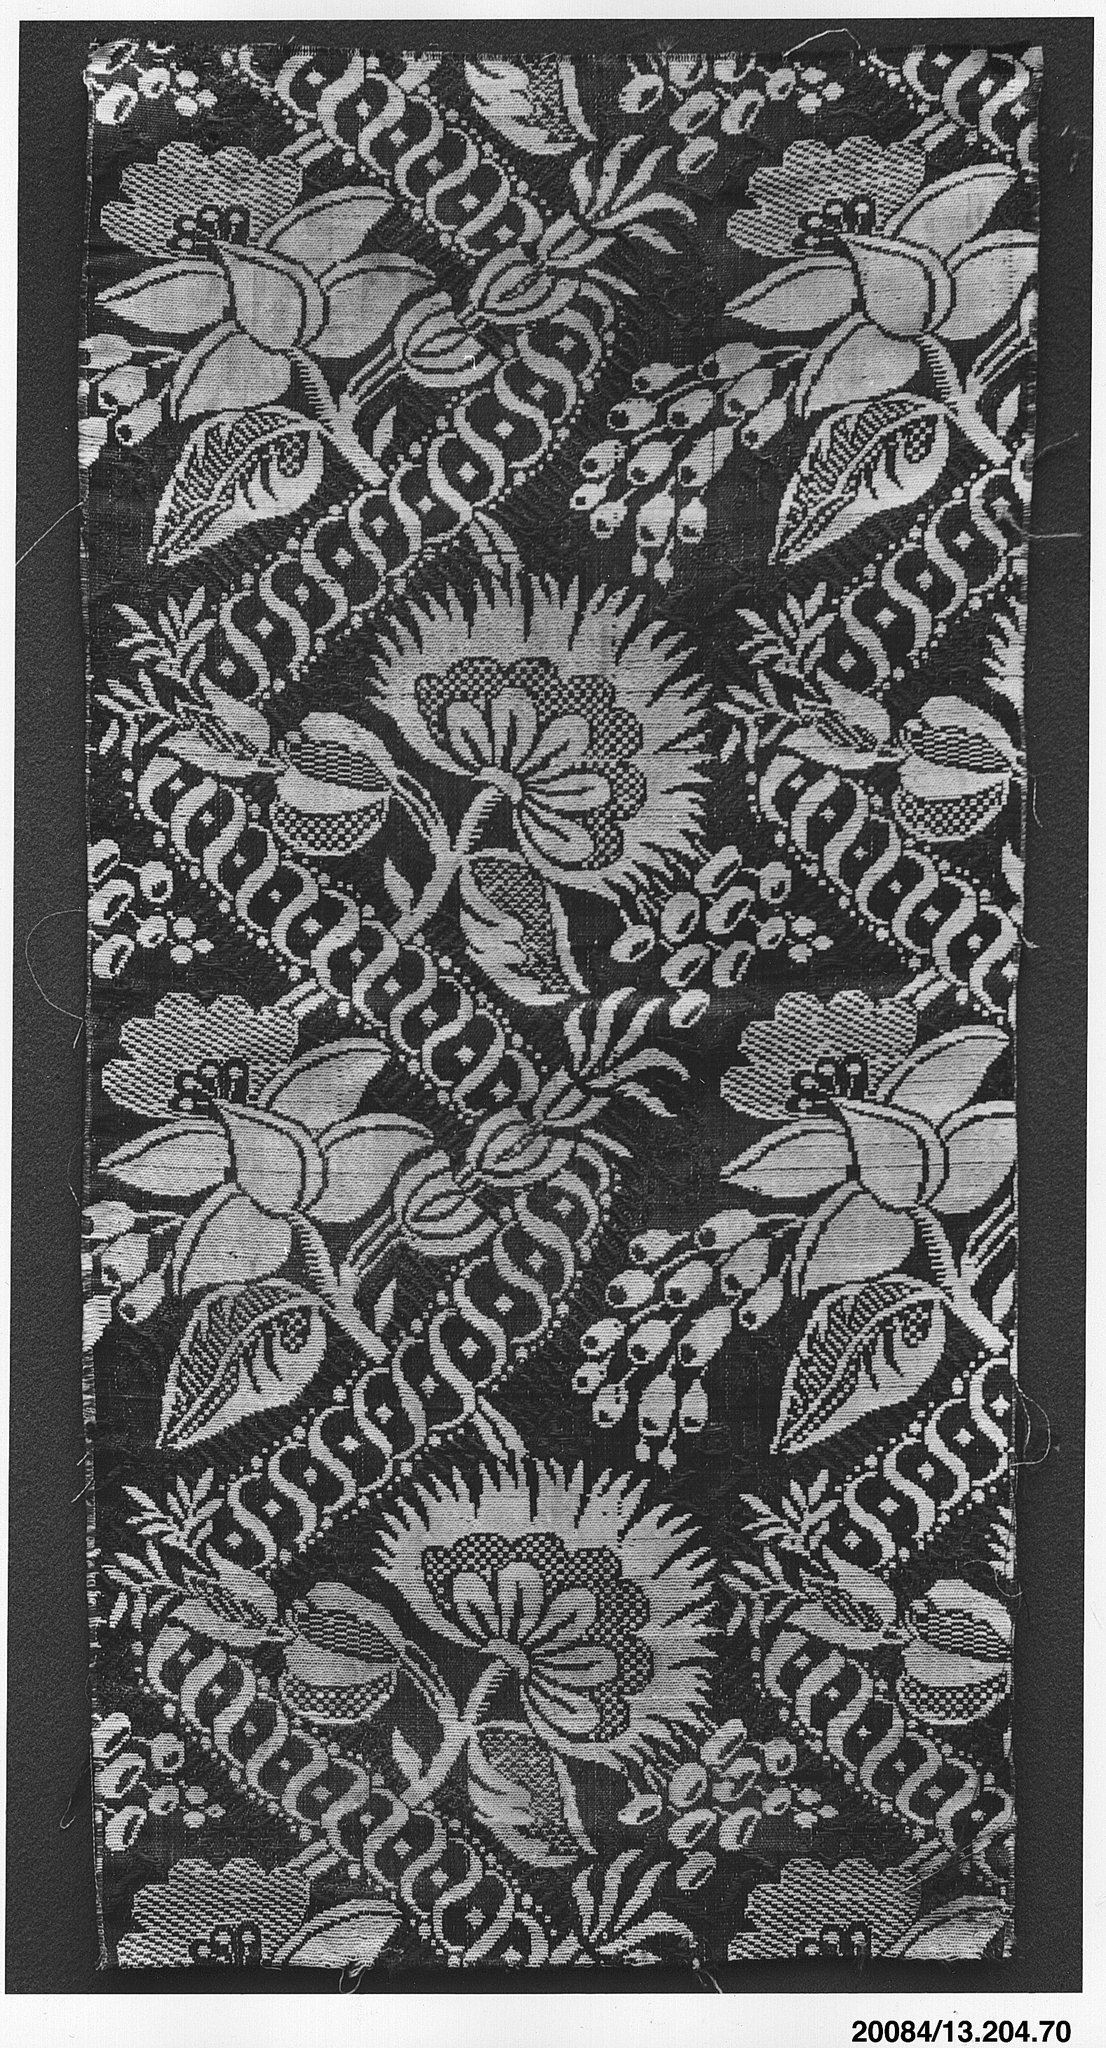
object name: piece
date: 1701-1800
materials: silk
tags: flowers,leaves